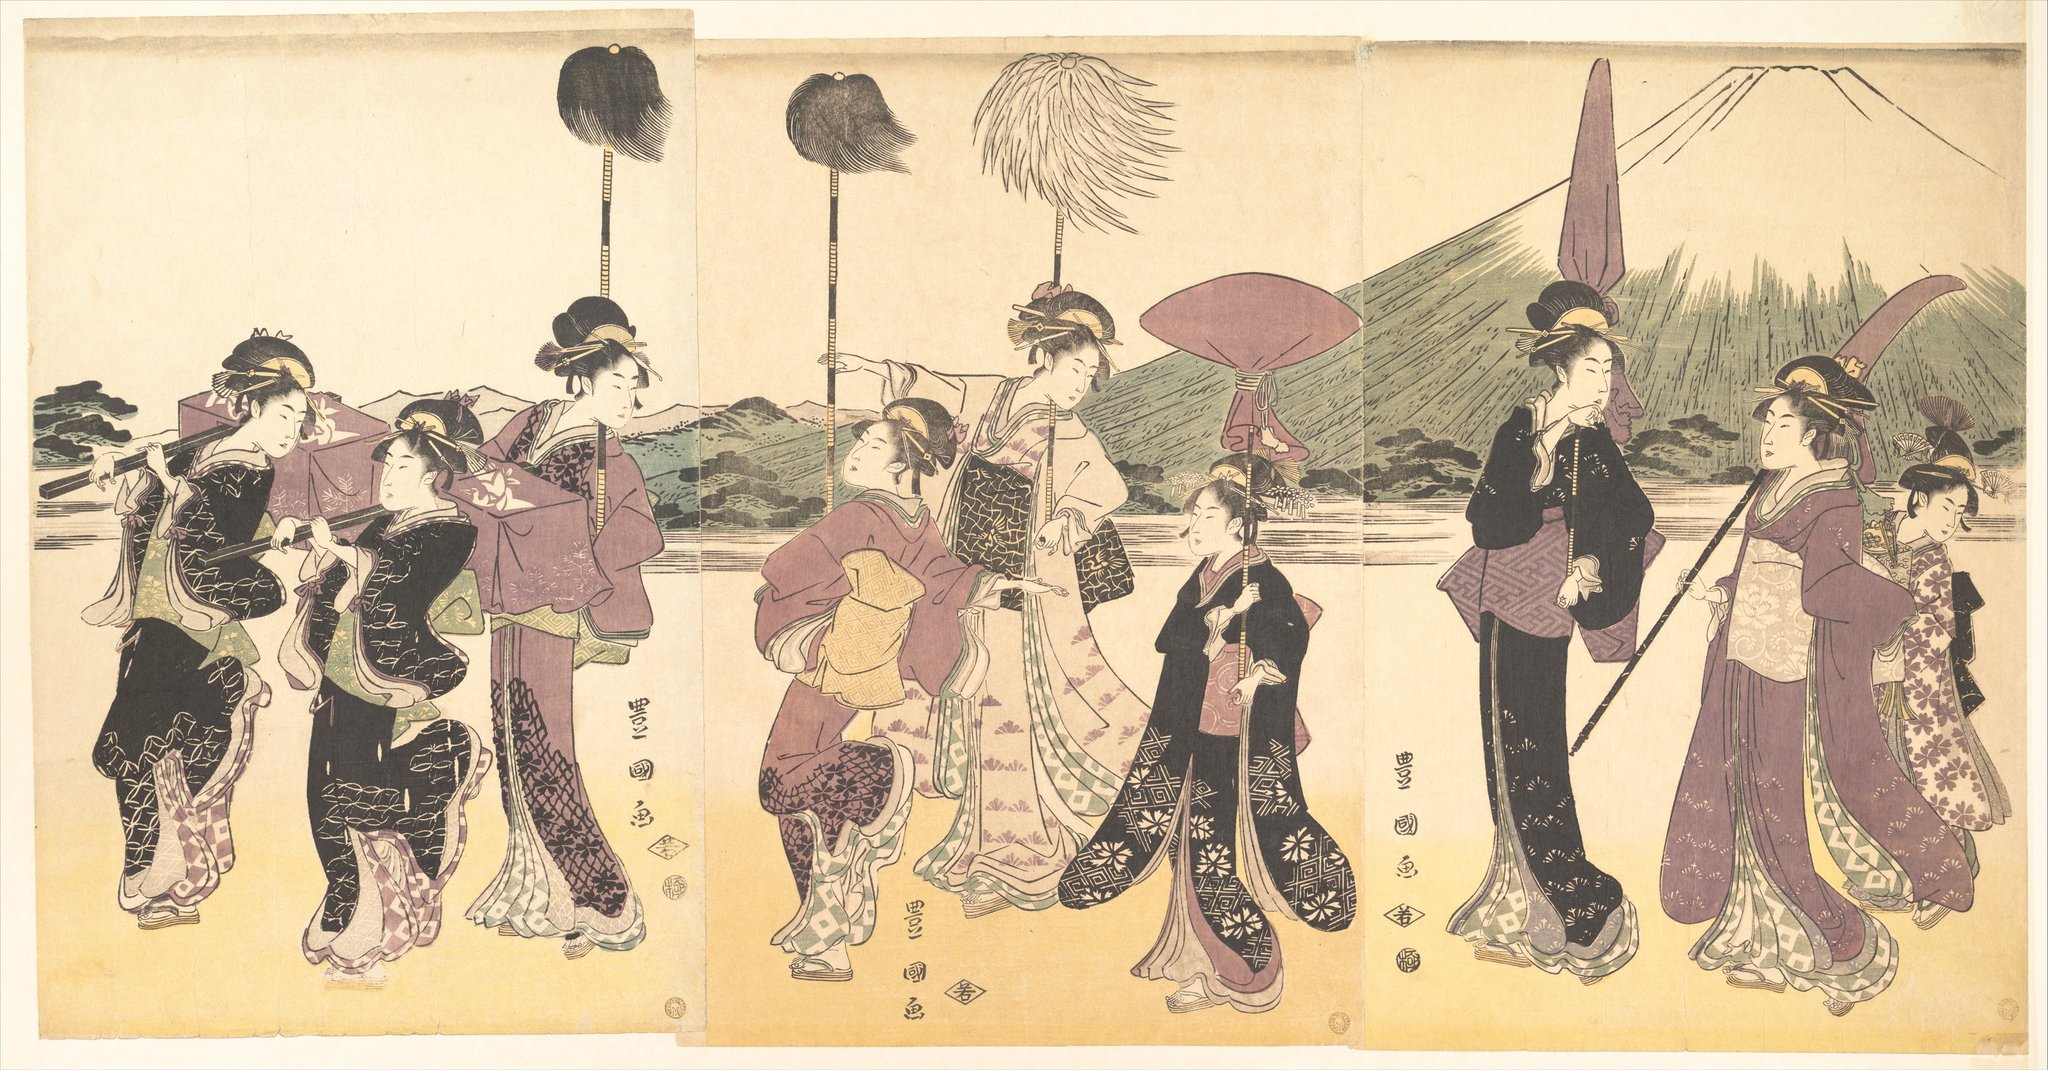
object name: print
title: Women Parading in an Imitation of the Cortege of a Daimyo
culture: japanese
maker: utagawa toyokuni i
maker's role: artist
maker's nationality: japanese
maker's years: 1769-1825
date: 1797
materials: ink, paper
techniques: woodblock print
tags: women,mountains